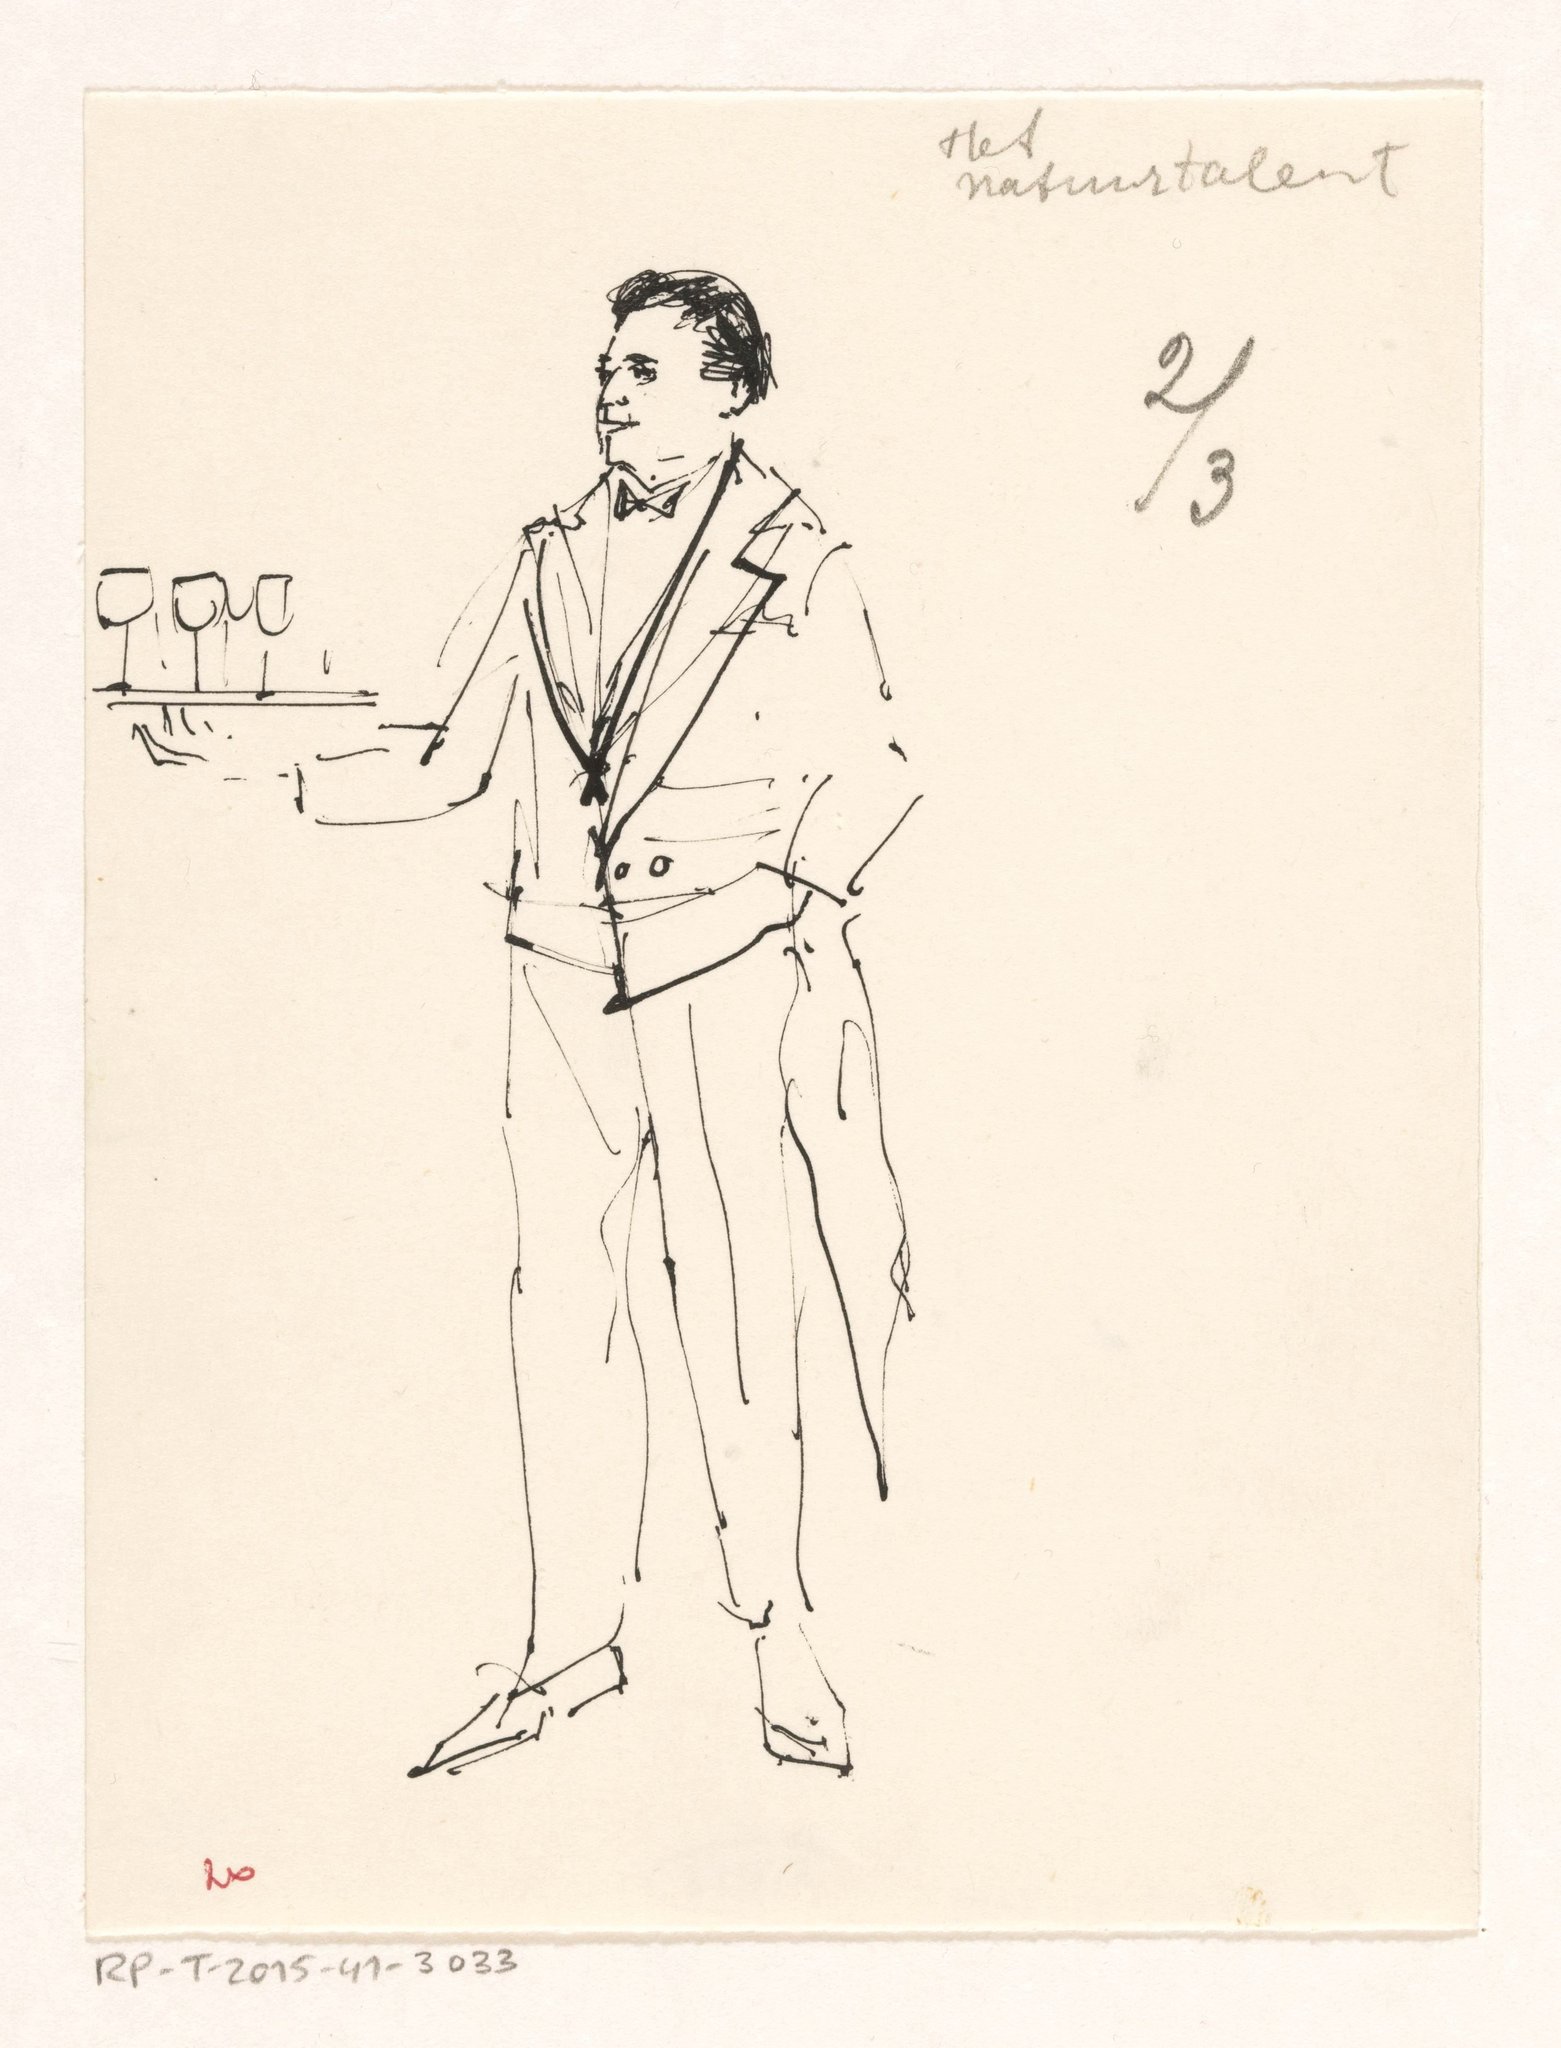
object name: drawing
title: Ober met dienblad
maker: Anonymous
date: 1930-1970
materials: ink, paper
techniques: pen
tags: head (human)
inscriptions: :, annotation: ‘Het/ natuurtalent’, number: ‘20’, collector's mark: Lugt 2228a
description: Een ober in een jacquet houdt een dienblad met wijnglazen in zijn hand.